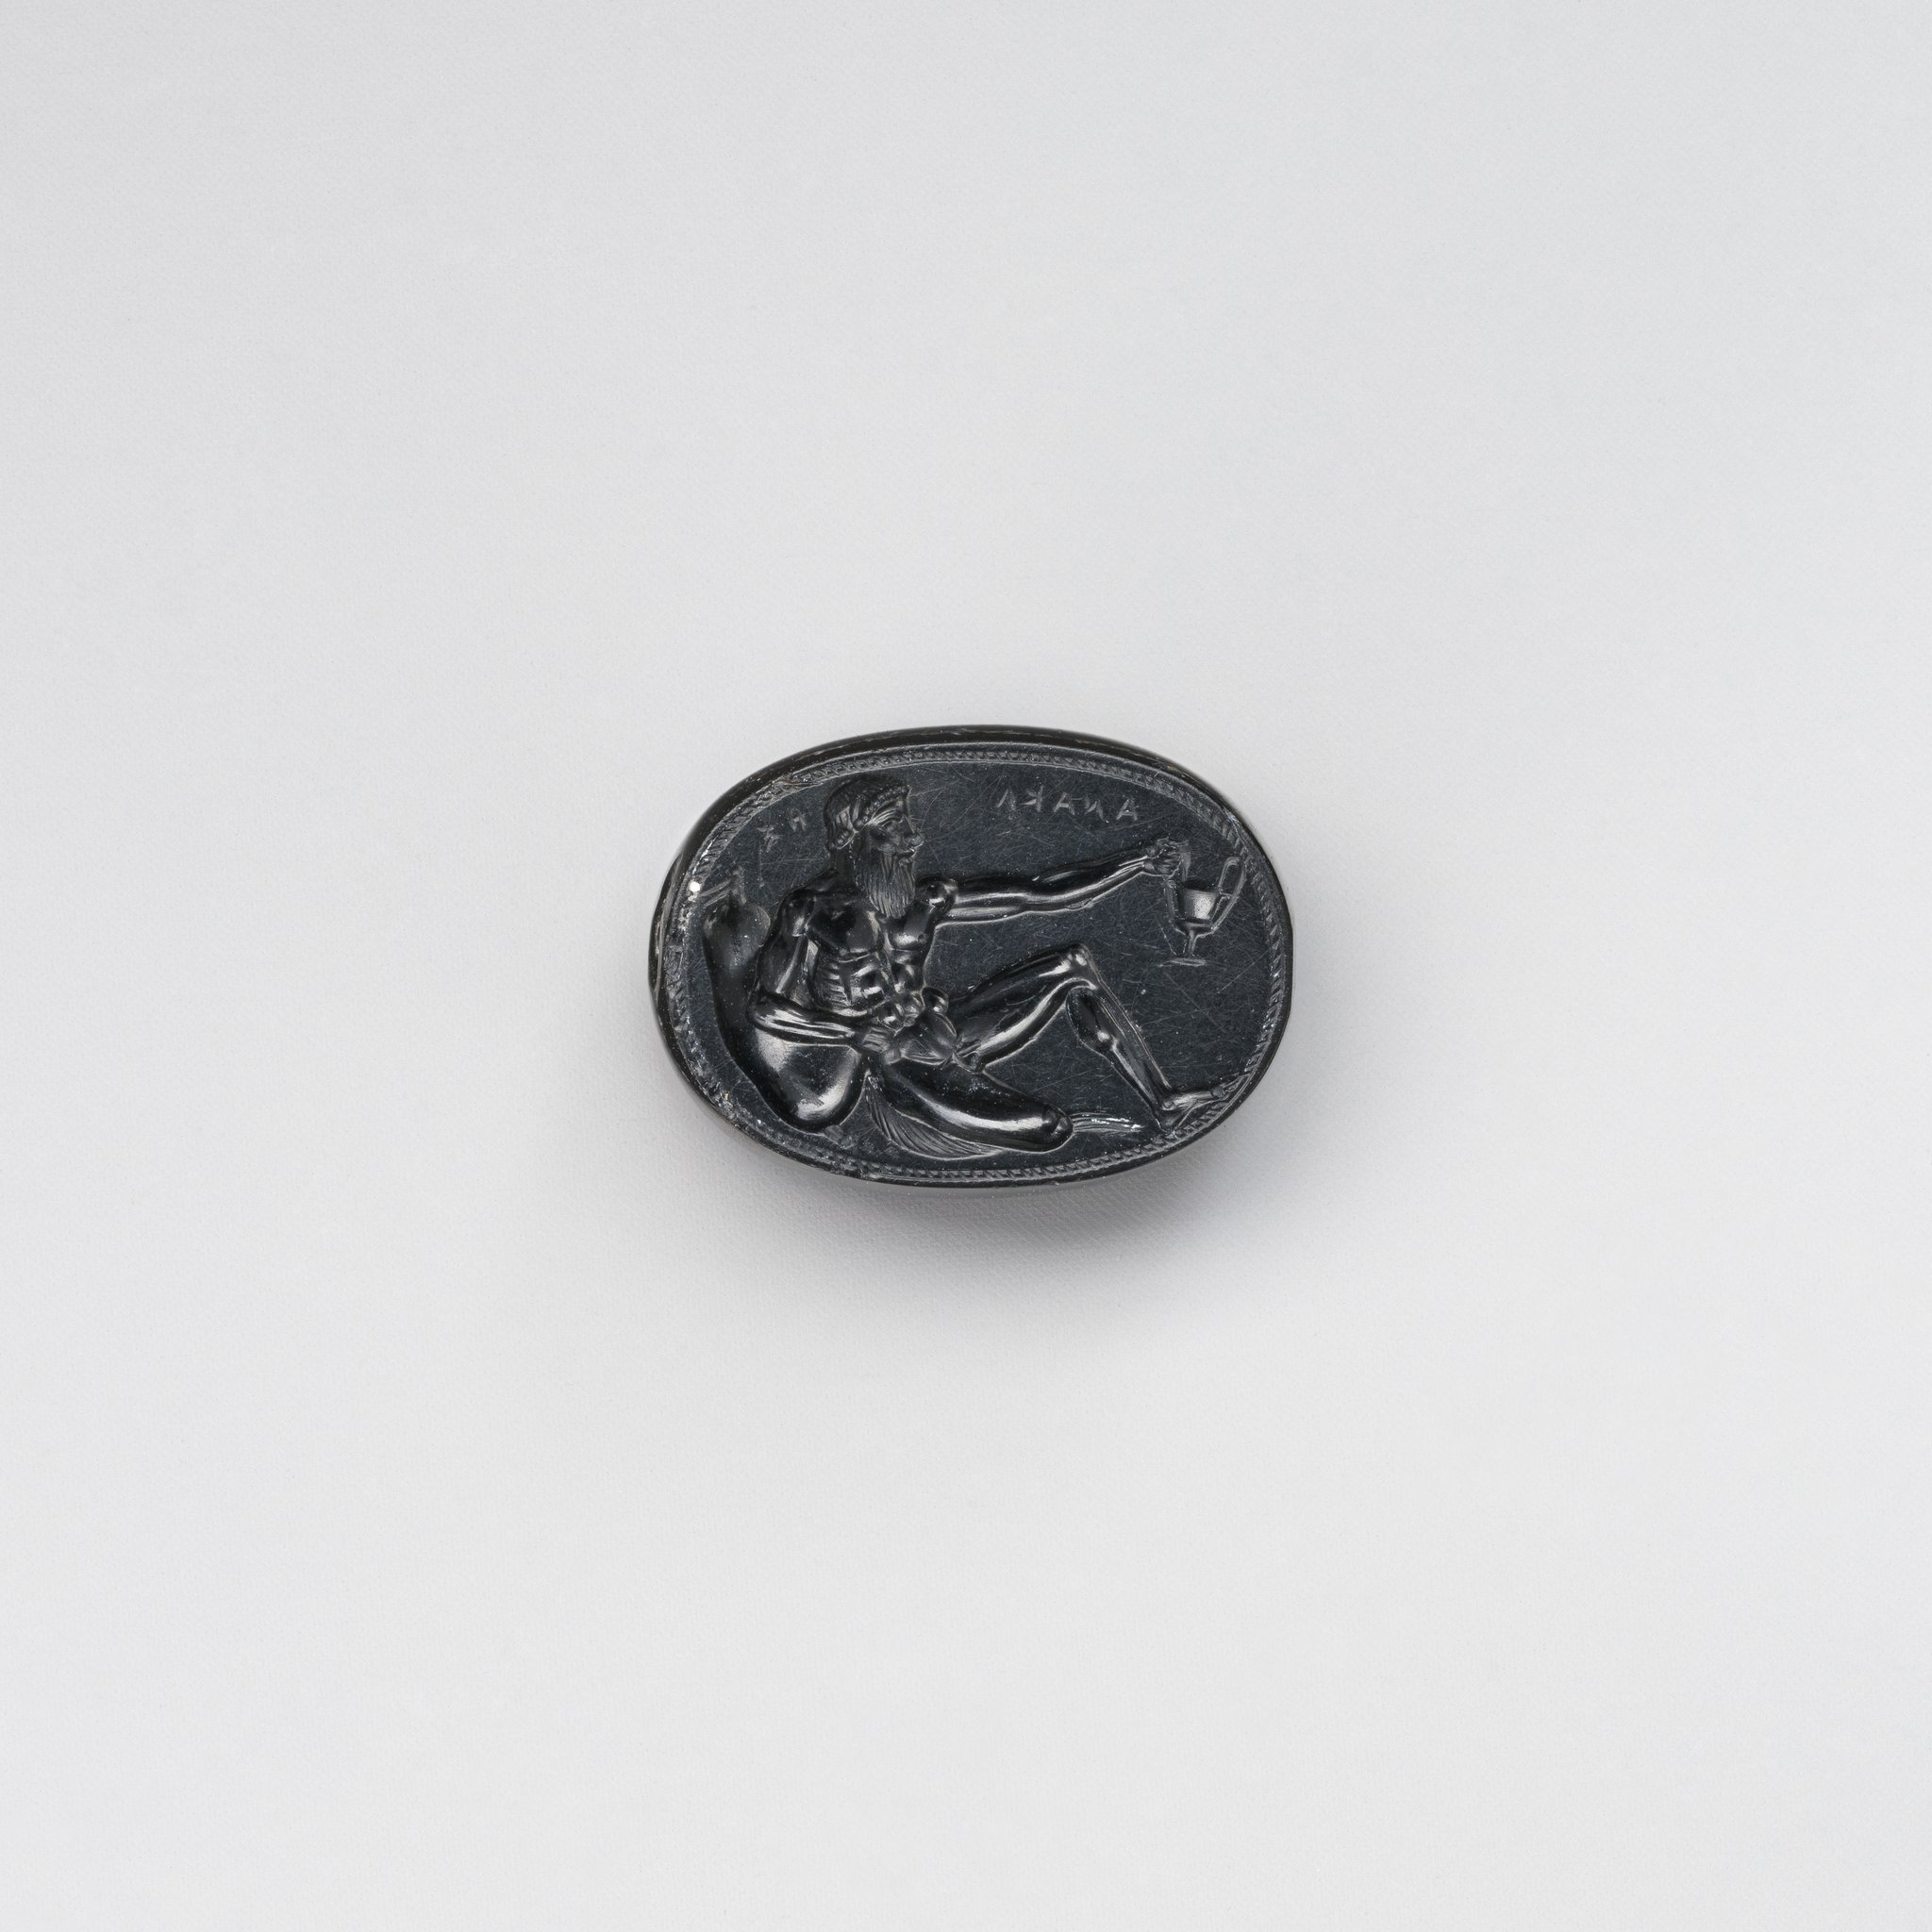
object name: scaraboid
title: Jasper scaraboid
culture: greek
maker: anakles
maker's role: artist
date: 500-468 BCE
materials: jasper